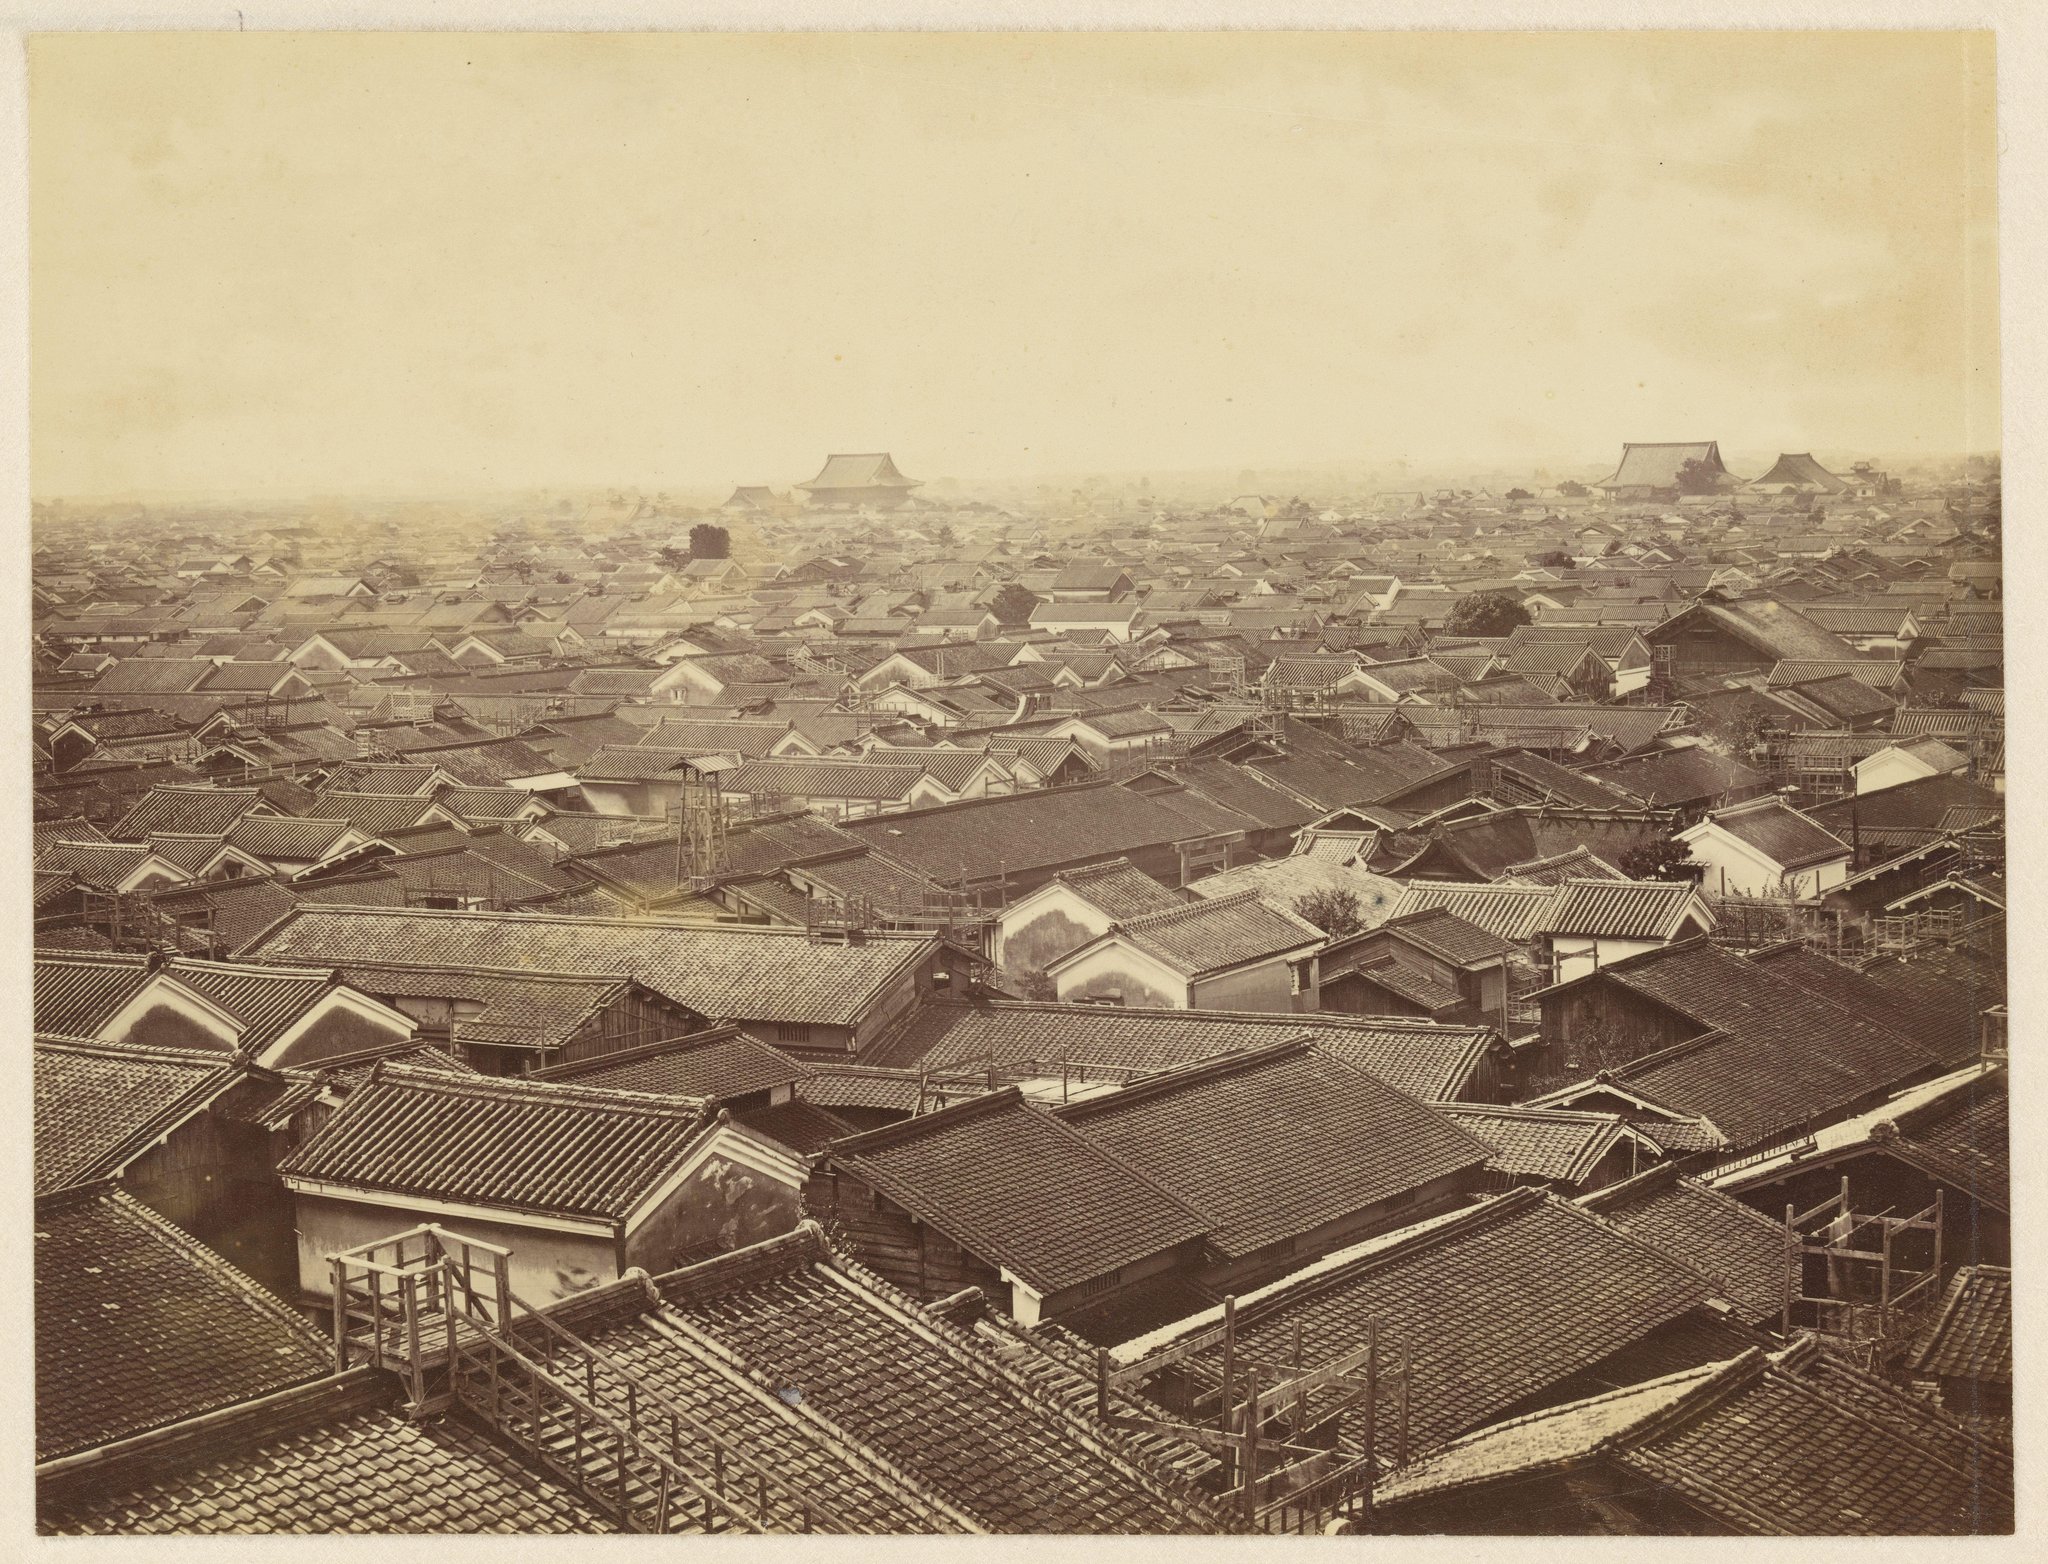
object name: photograph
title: View of an unidentified city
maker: Anonymous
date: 1865-1875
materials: paper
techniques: albumen print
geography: japan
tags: osaka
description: Many Japanese cities have changed beyond recognition over the past 150 years. That makes it difficult to be sure which one is pictured here. Since only the Bauduins themselves, and their friends and family, saw these photos, there was no reason to write anything on the back. A verbal explanation sufficed. That is, until years later, when there was no one left to explain.